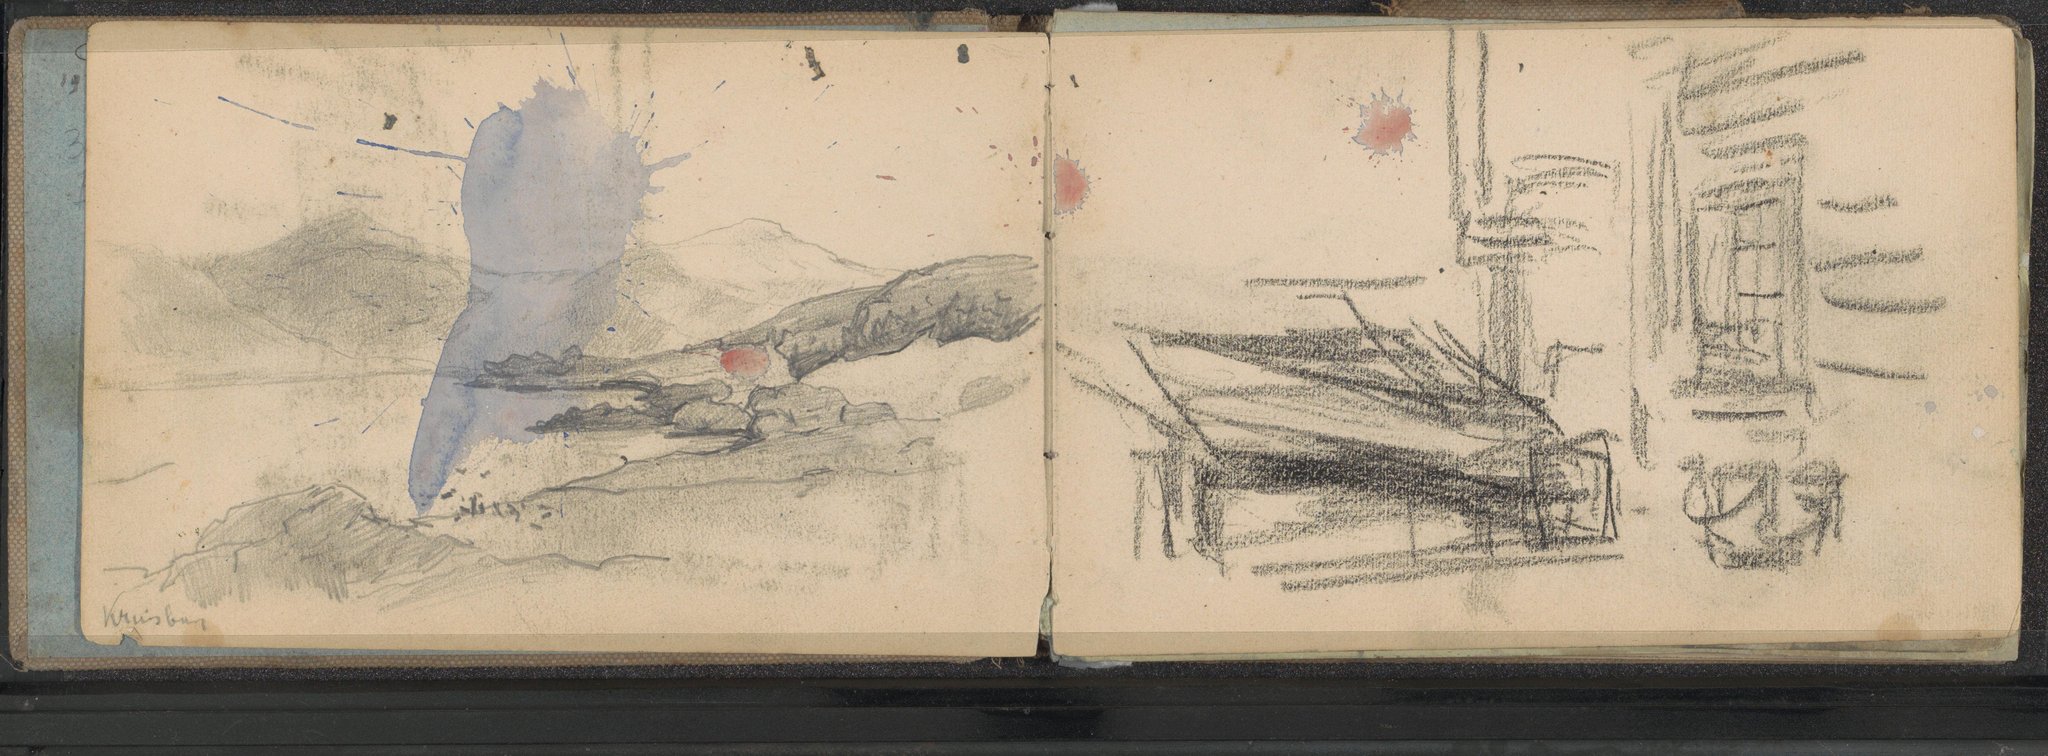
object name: sketchbook leaf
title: Gezicht op de Kruisbaai te Nova Zembla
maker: louis apol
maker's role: draughtsman, painter, print maker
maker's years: 1850-1936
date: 1880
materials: paper, pencil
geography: novaya zemlya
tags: coast (in polar regions), fjord, sea loch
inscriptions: annotation: ‘Kruisbaai’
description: Blad 1 verso uit een schetsboek met 35 bladen betekend tijdens de expeditie naar Nova Zembla in 1880.